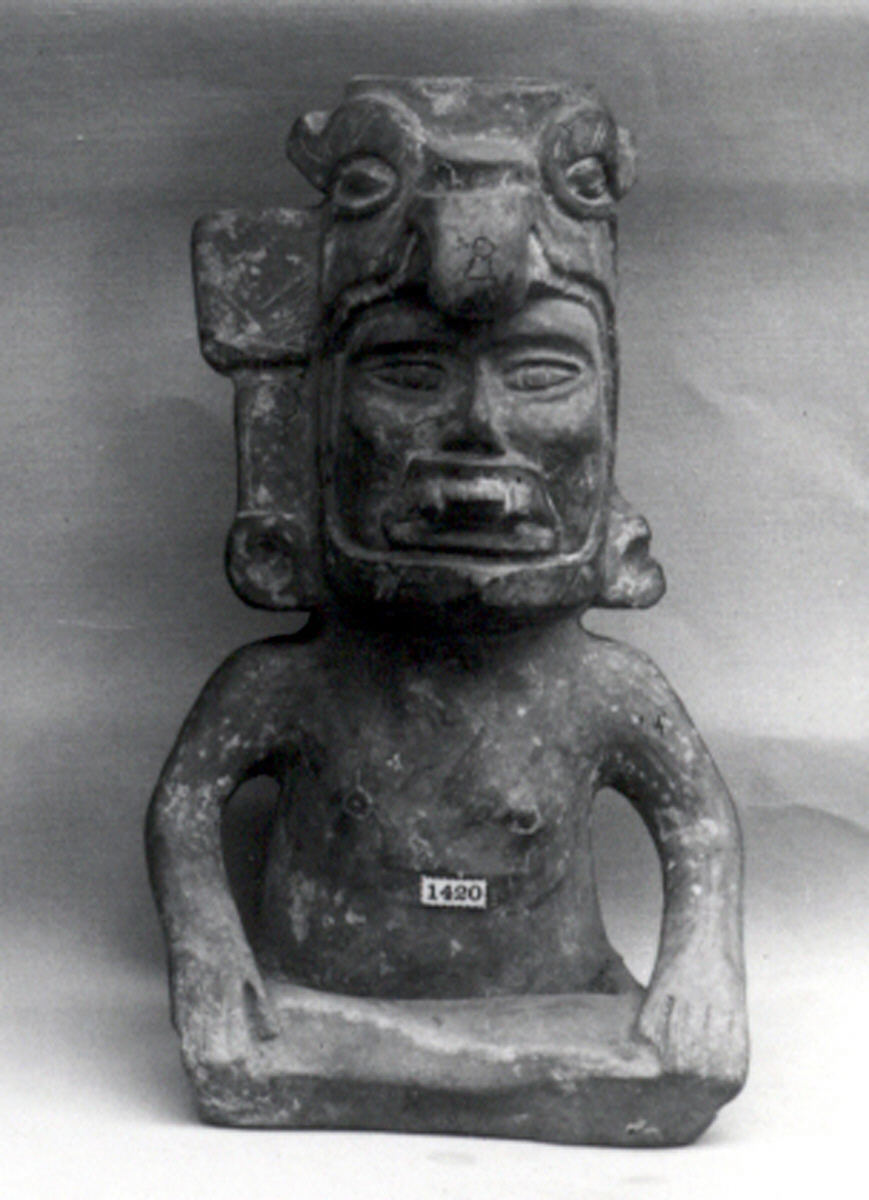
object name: vessel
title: Figure Vessel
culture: monte alban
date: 1-700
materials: ceramic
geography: mexico